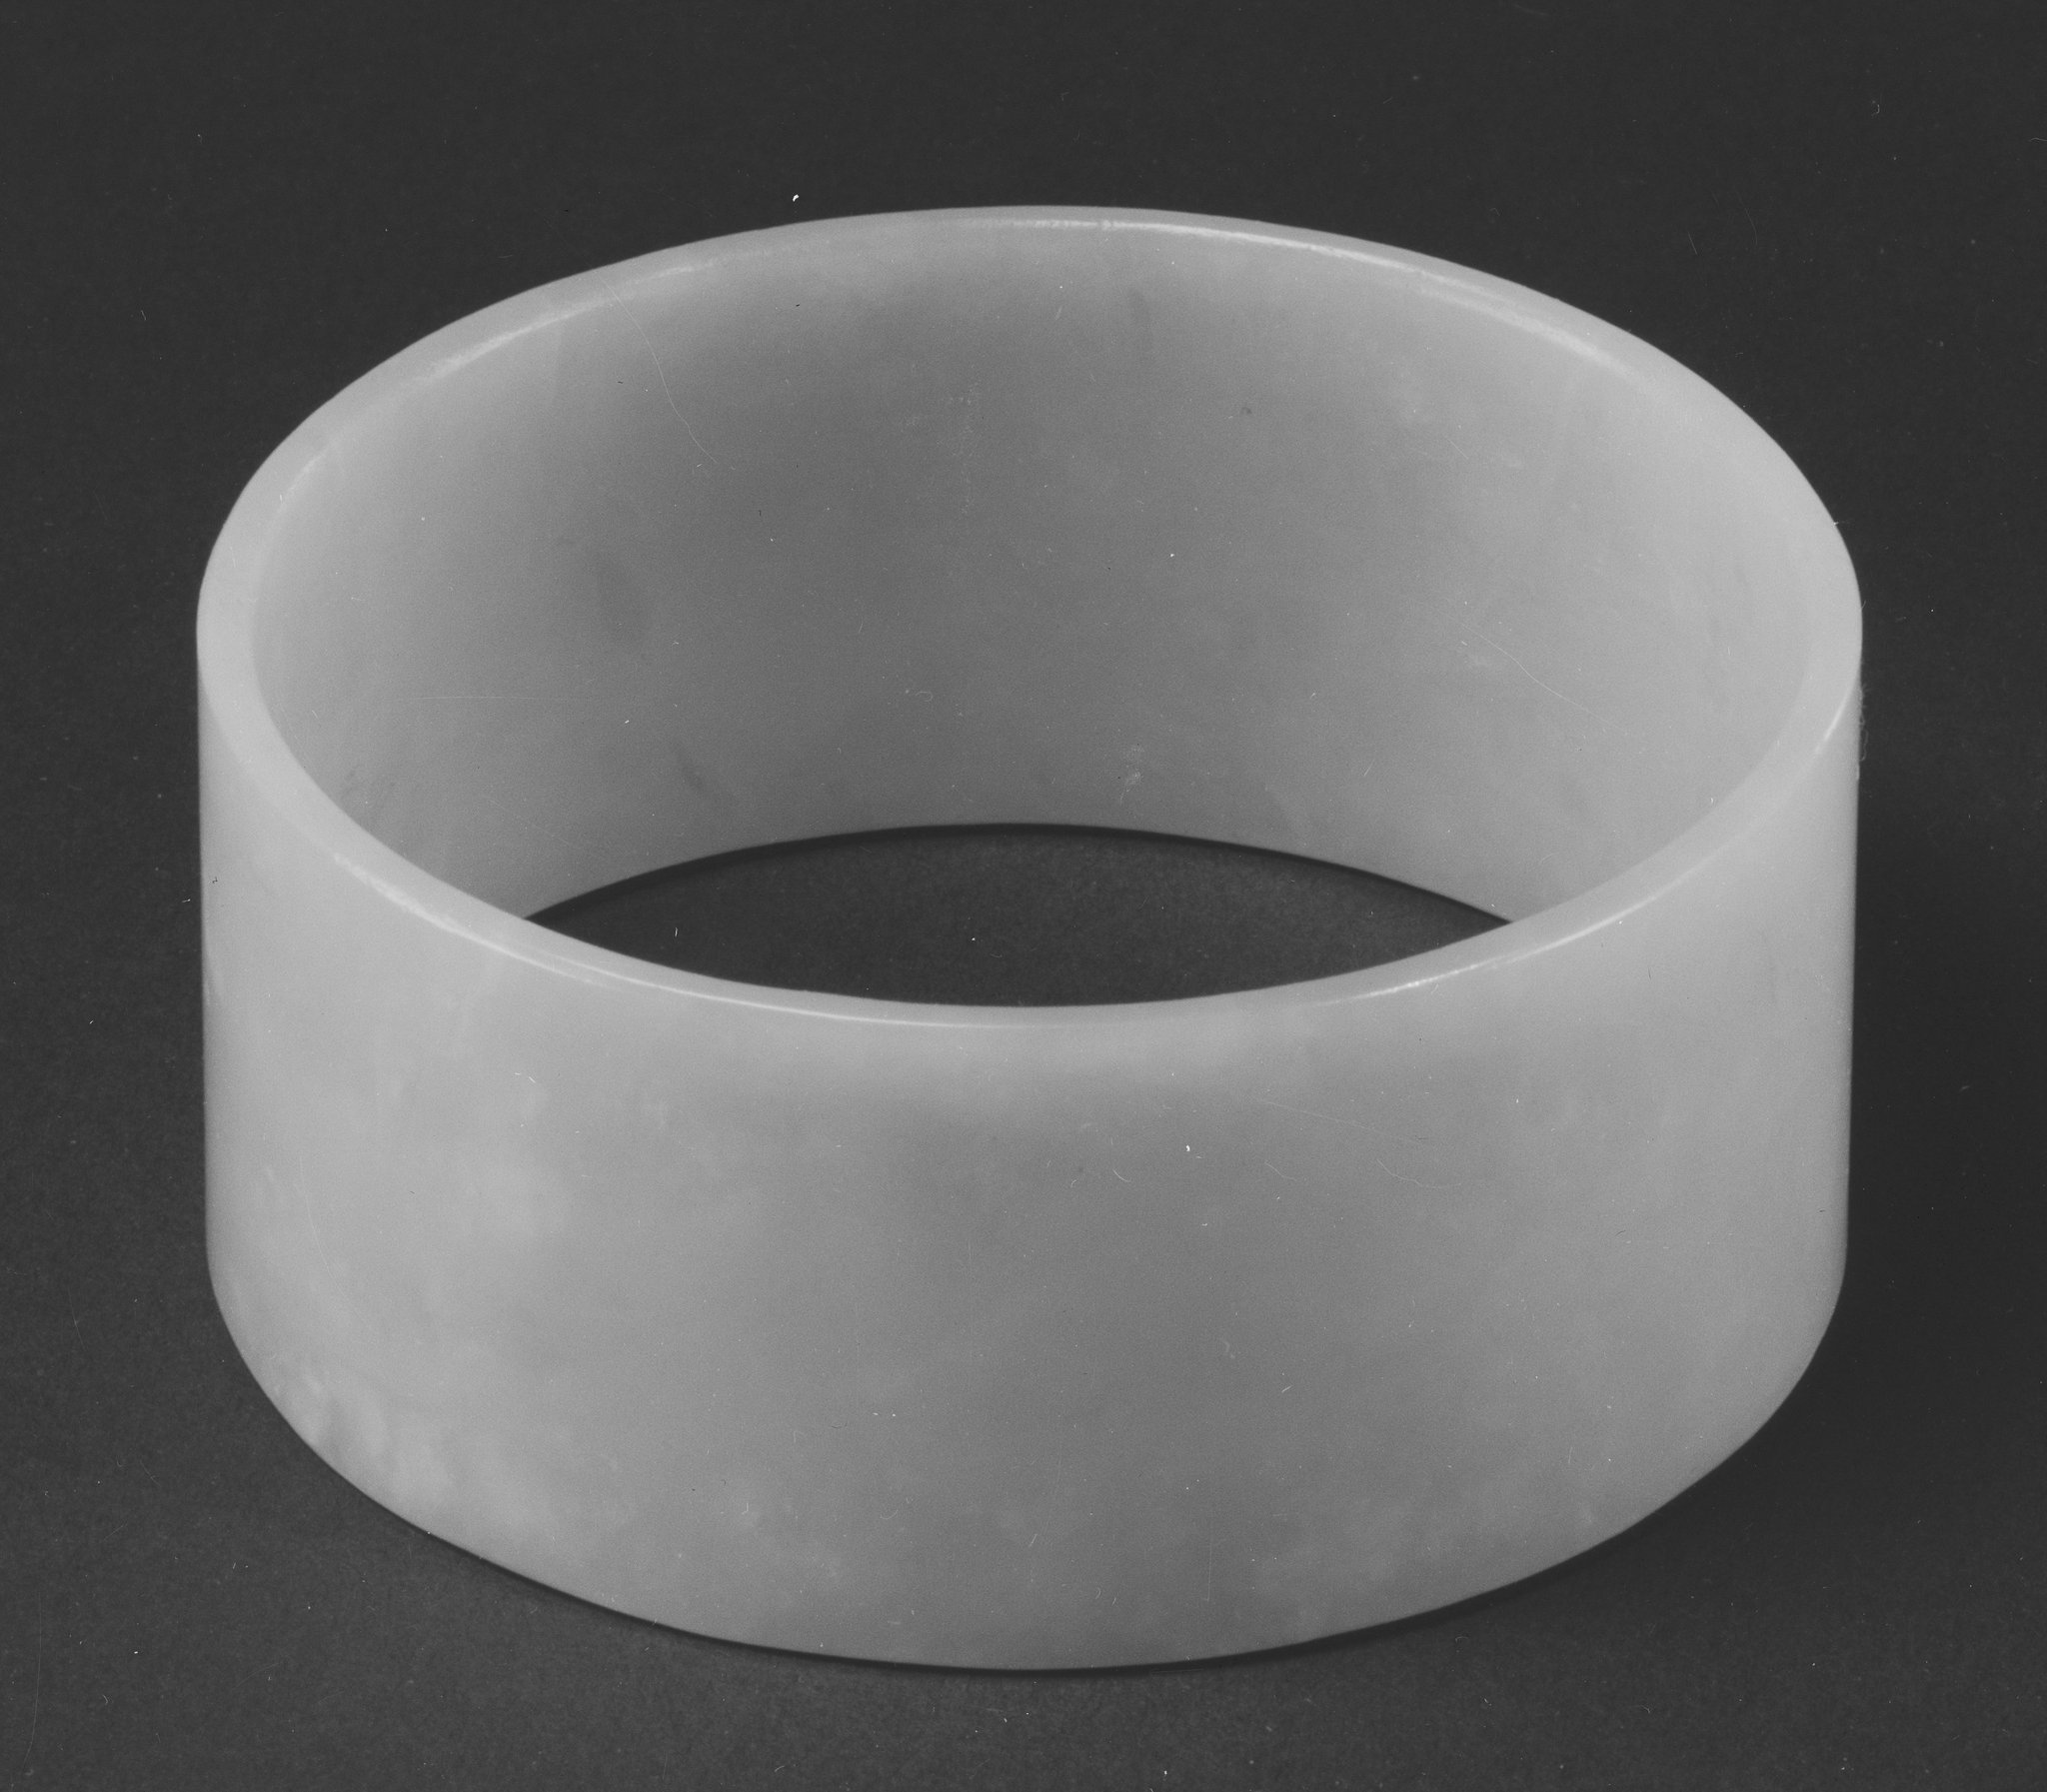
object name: bracelet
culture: chinese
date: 2400-2000 BCE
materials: jade